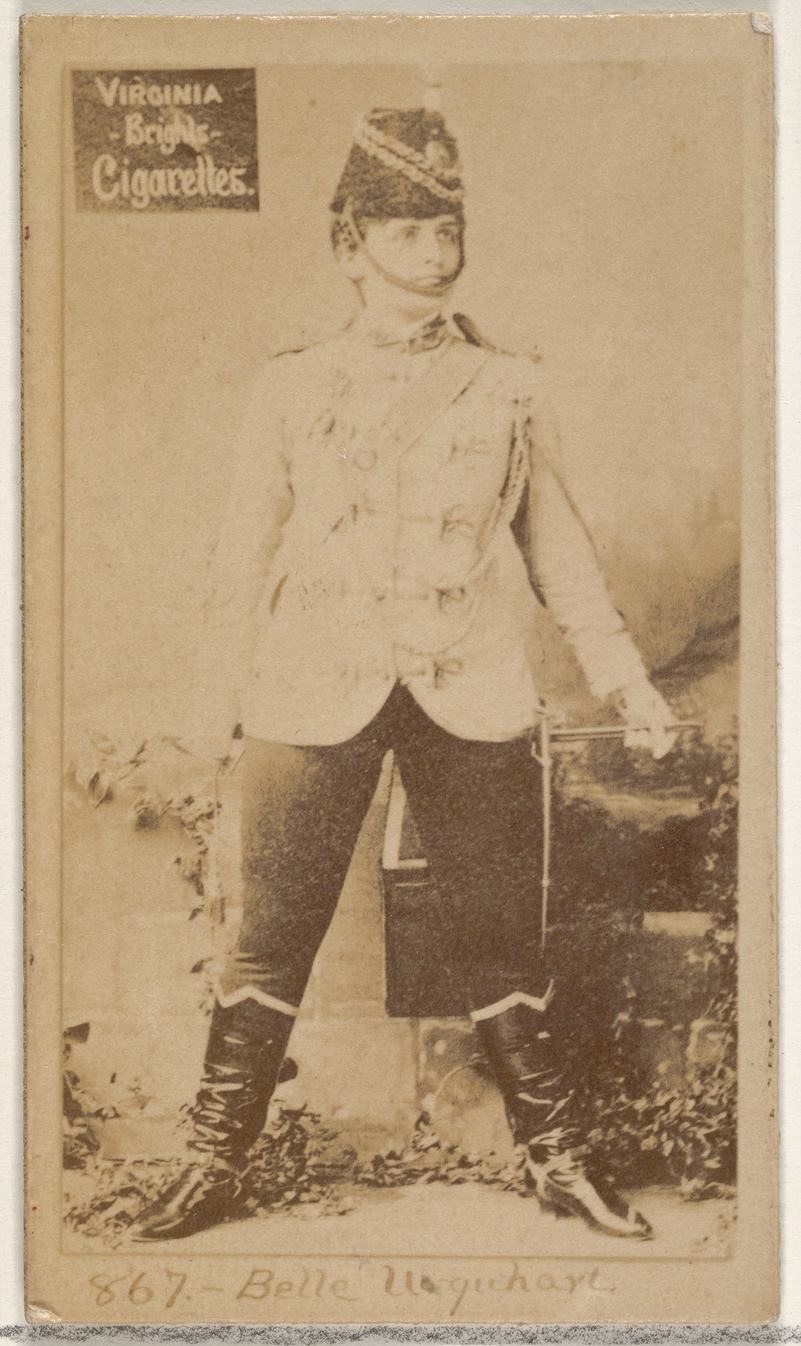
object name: photograph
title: Card 867, Belle Urquhart, from the Actors and Actresses series (N45, Type 2) for Virginia Brights Cigarettes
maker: allen & ginter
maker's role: publisher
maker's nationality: american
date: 1888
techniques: albumen silver print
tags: portraits,women,actresses